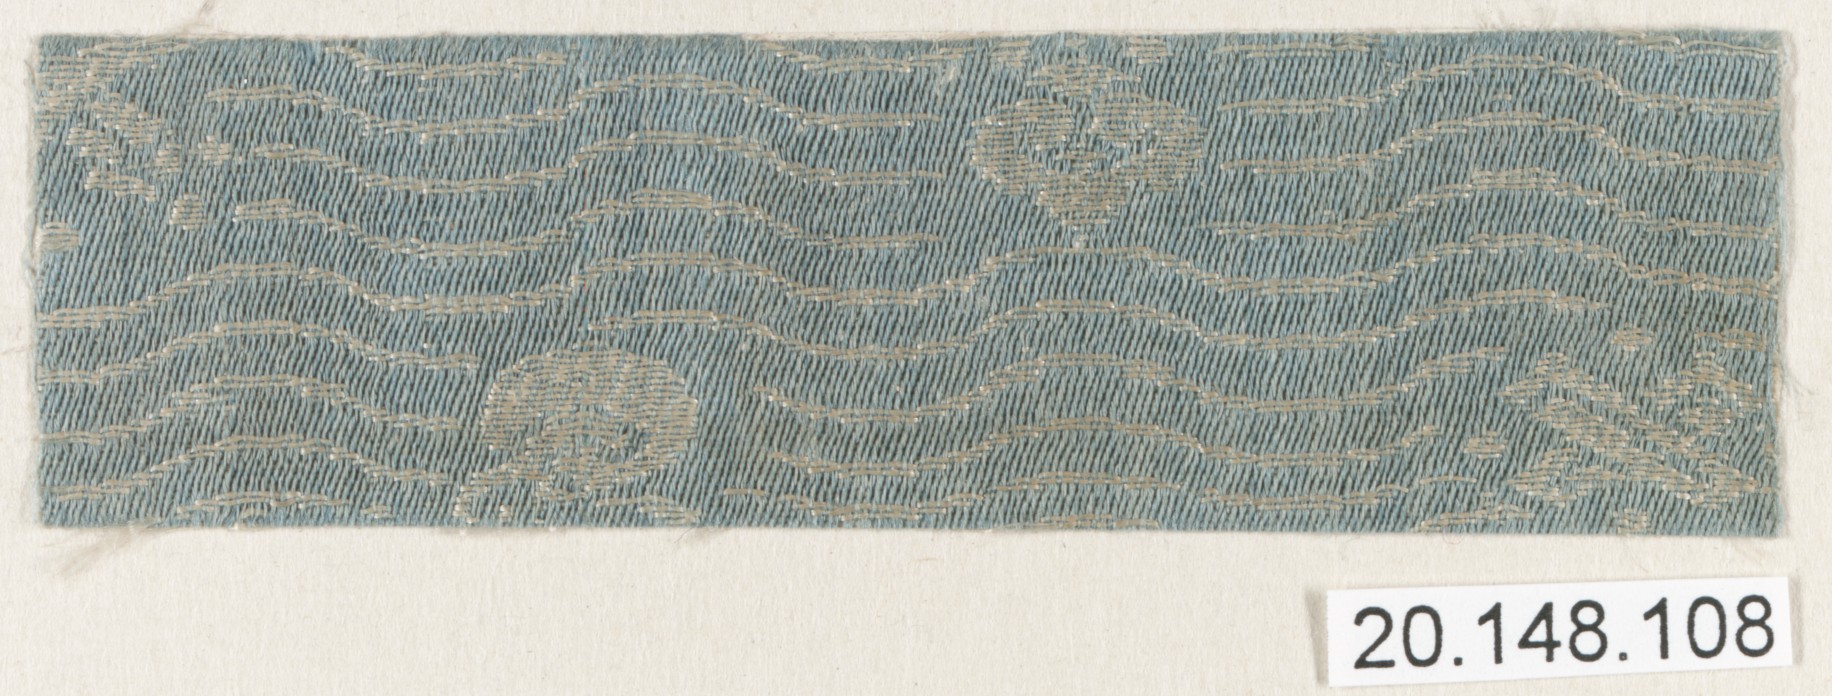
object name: piece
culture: japanese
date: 1601-1700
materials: silk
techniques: compound weave